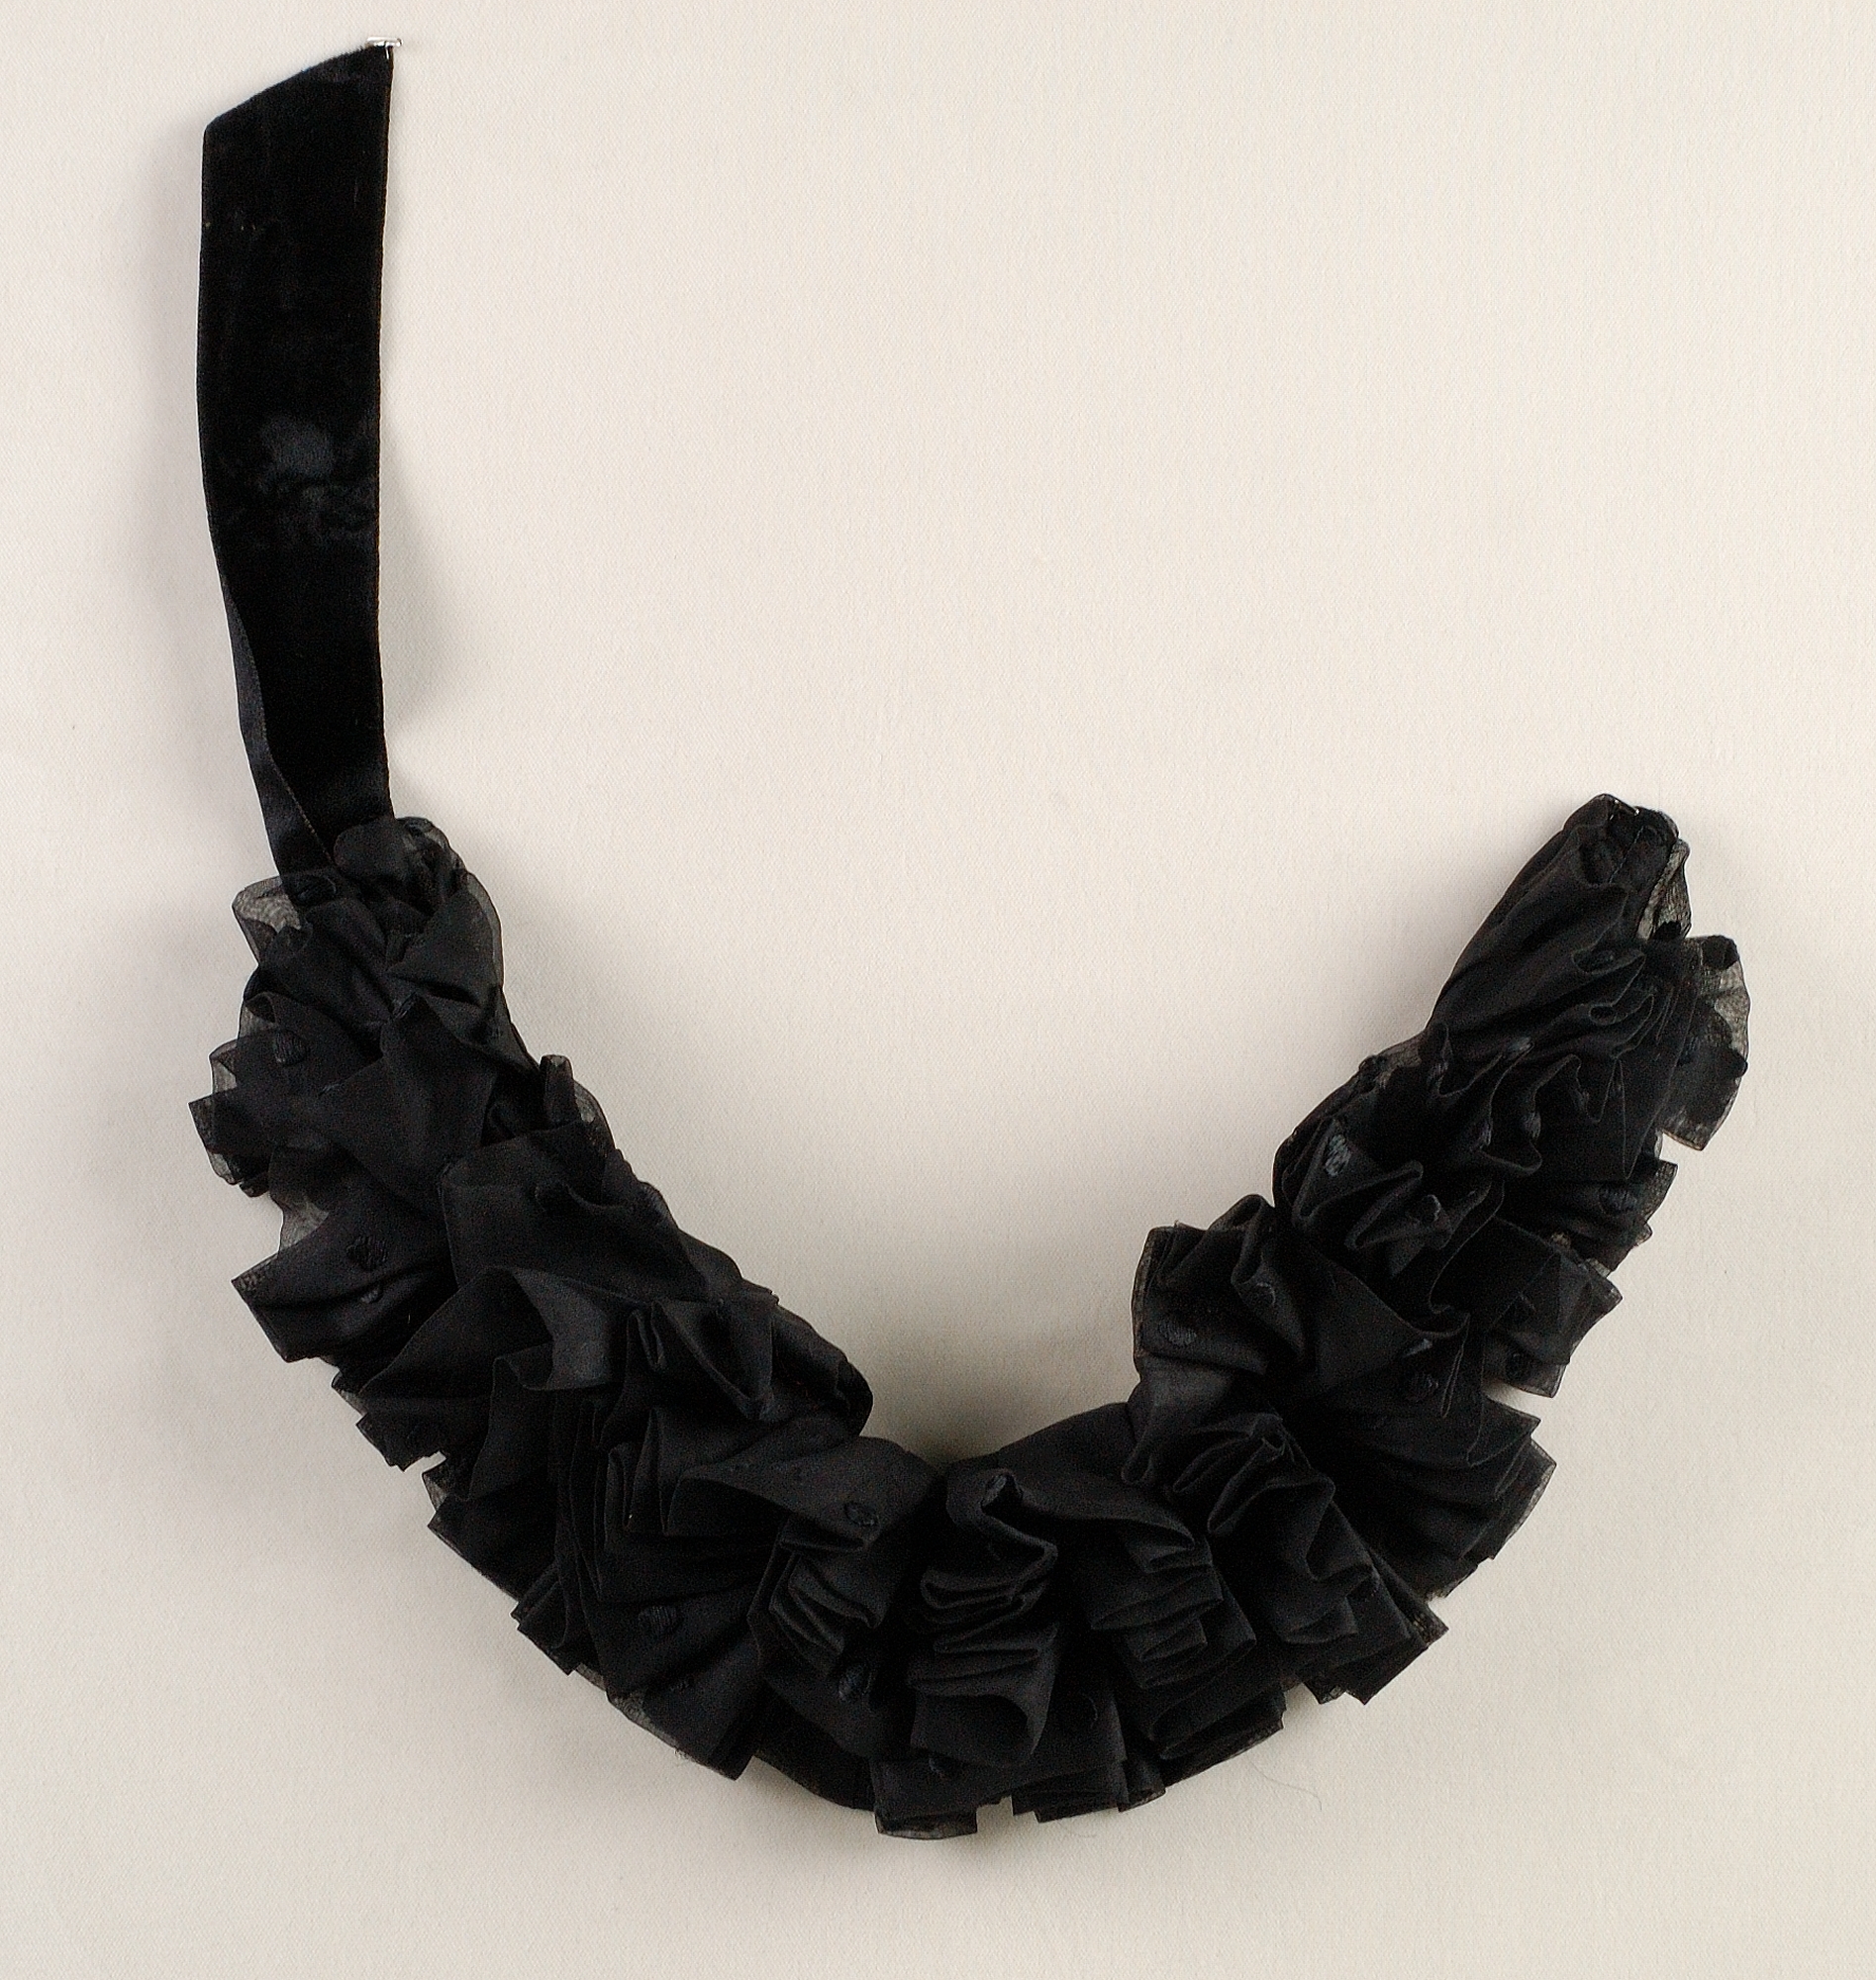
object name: collar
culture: american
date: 1895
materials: silk